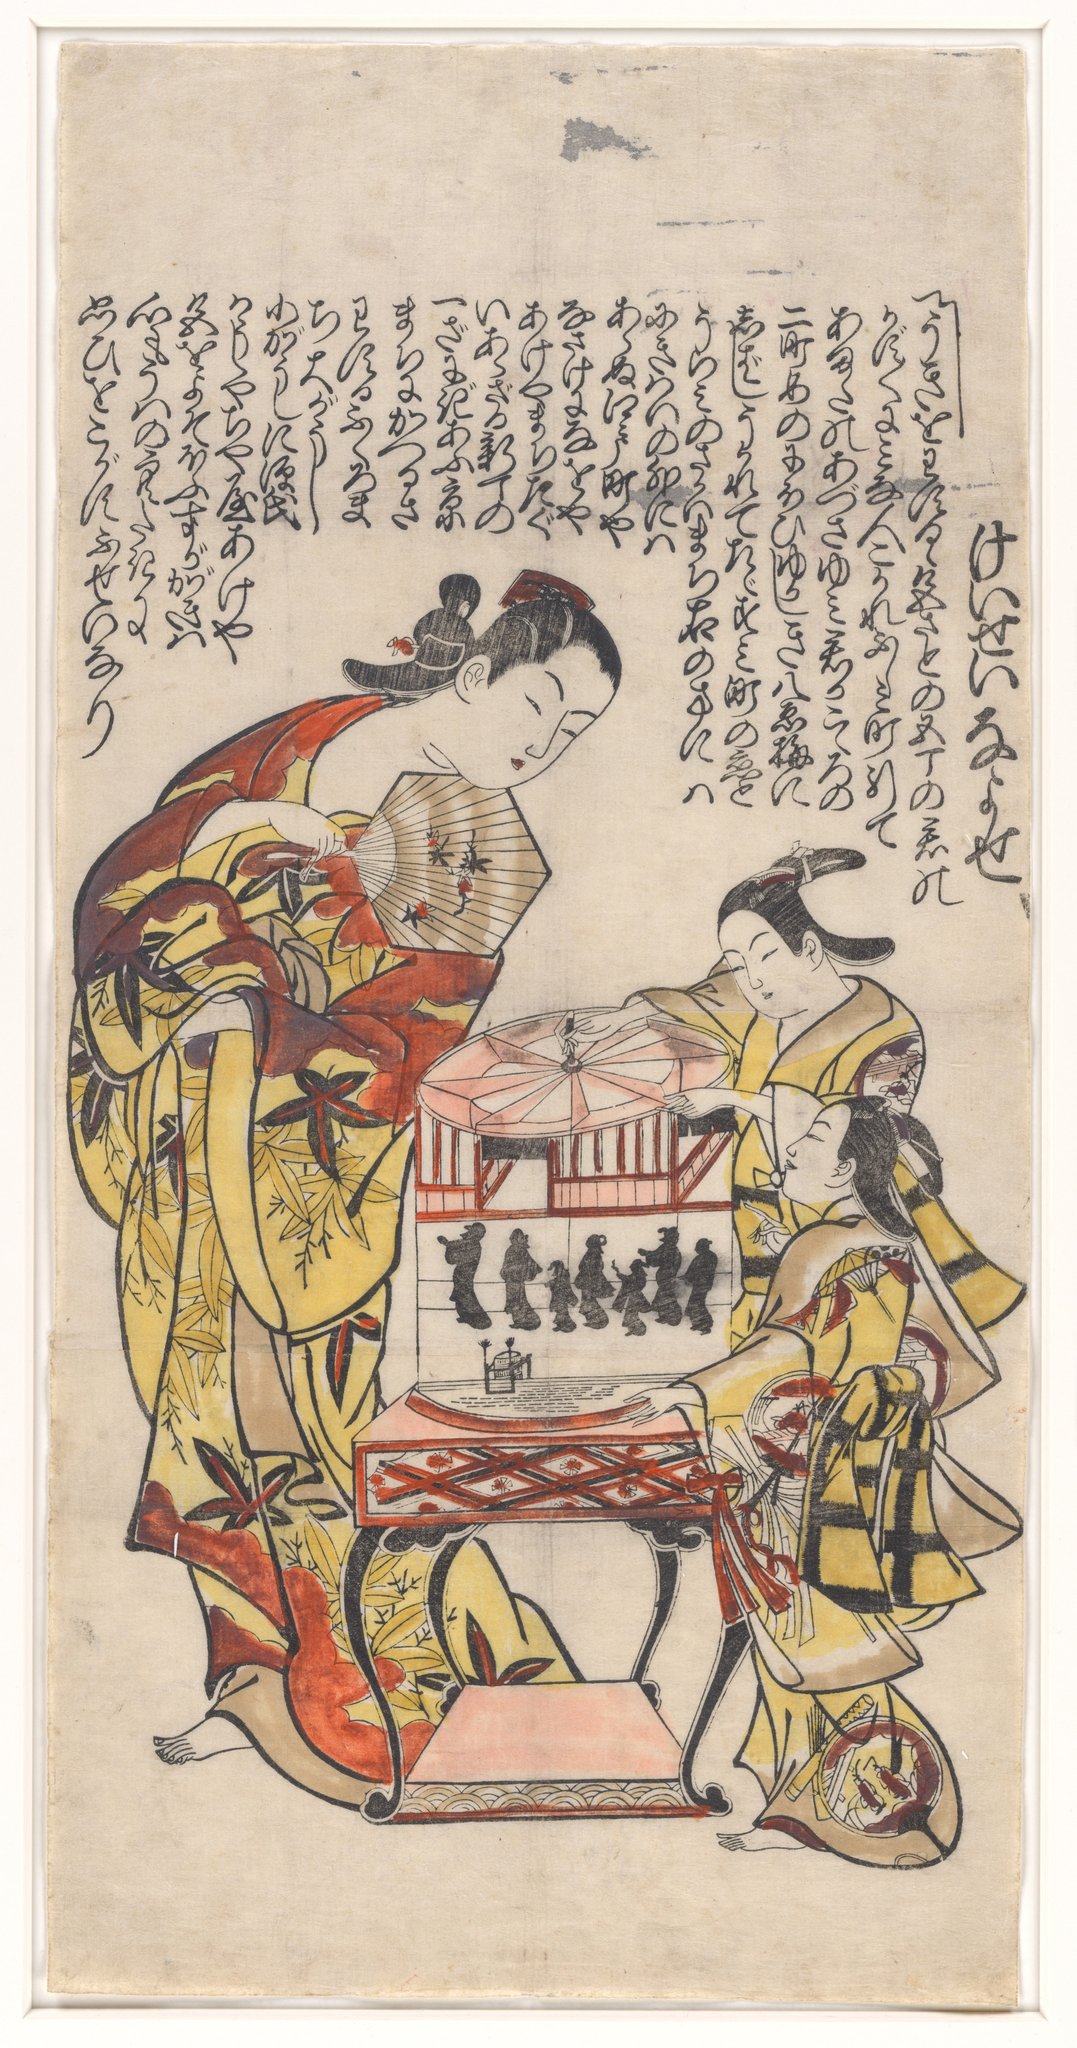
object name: woodblock print tan e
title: A Courtesan and Her Attendants with a Revolving Shadow Lantern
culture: japanese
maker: okumura masanobu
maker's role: artist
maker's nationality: japanese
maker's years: 1686-1764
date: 1715-1720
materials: ink, paper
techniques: woodblock print